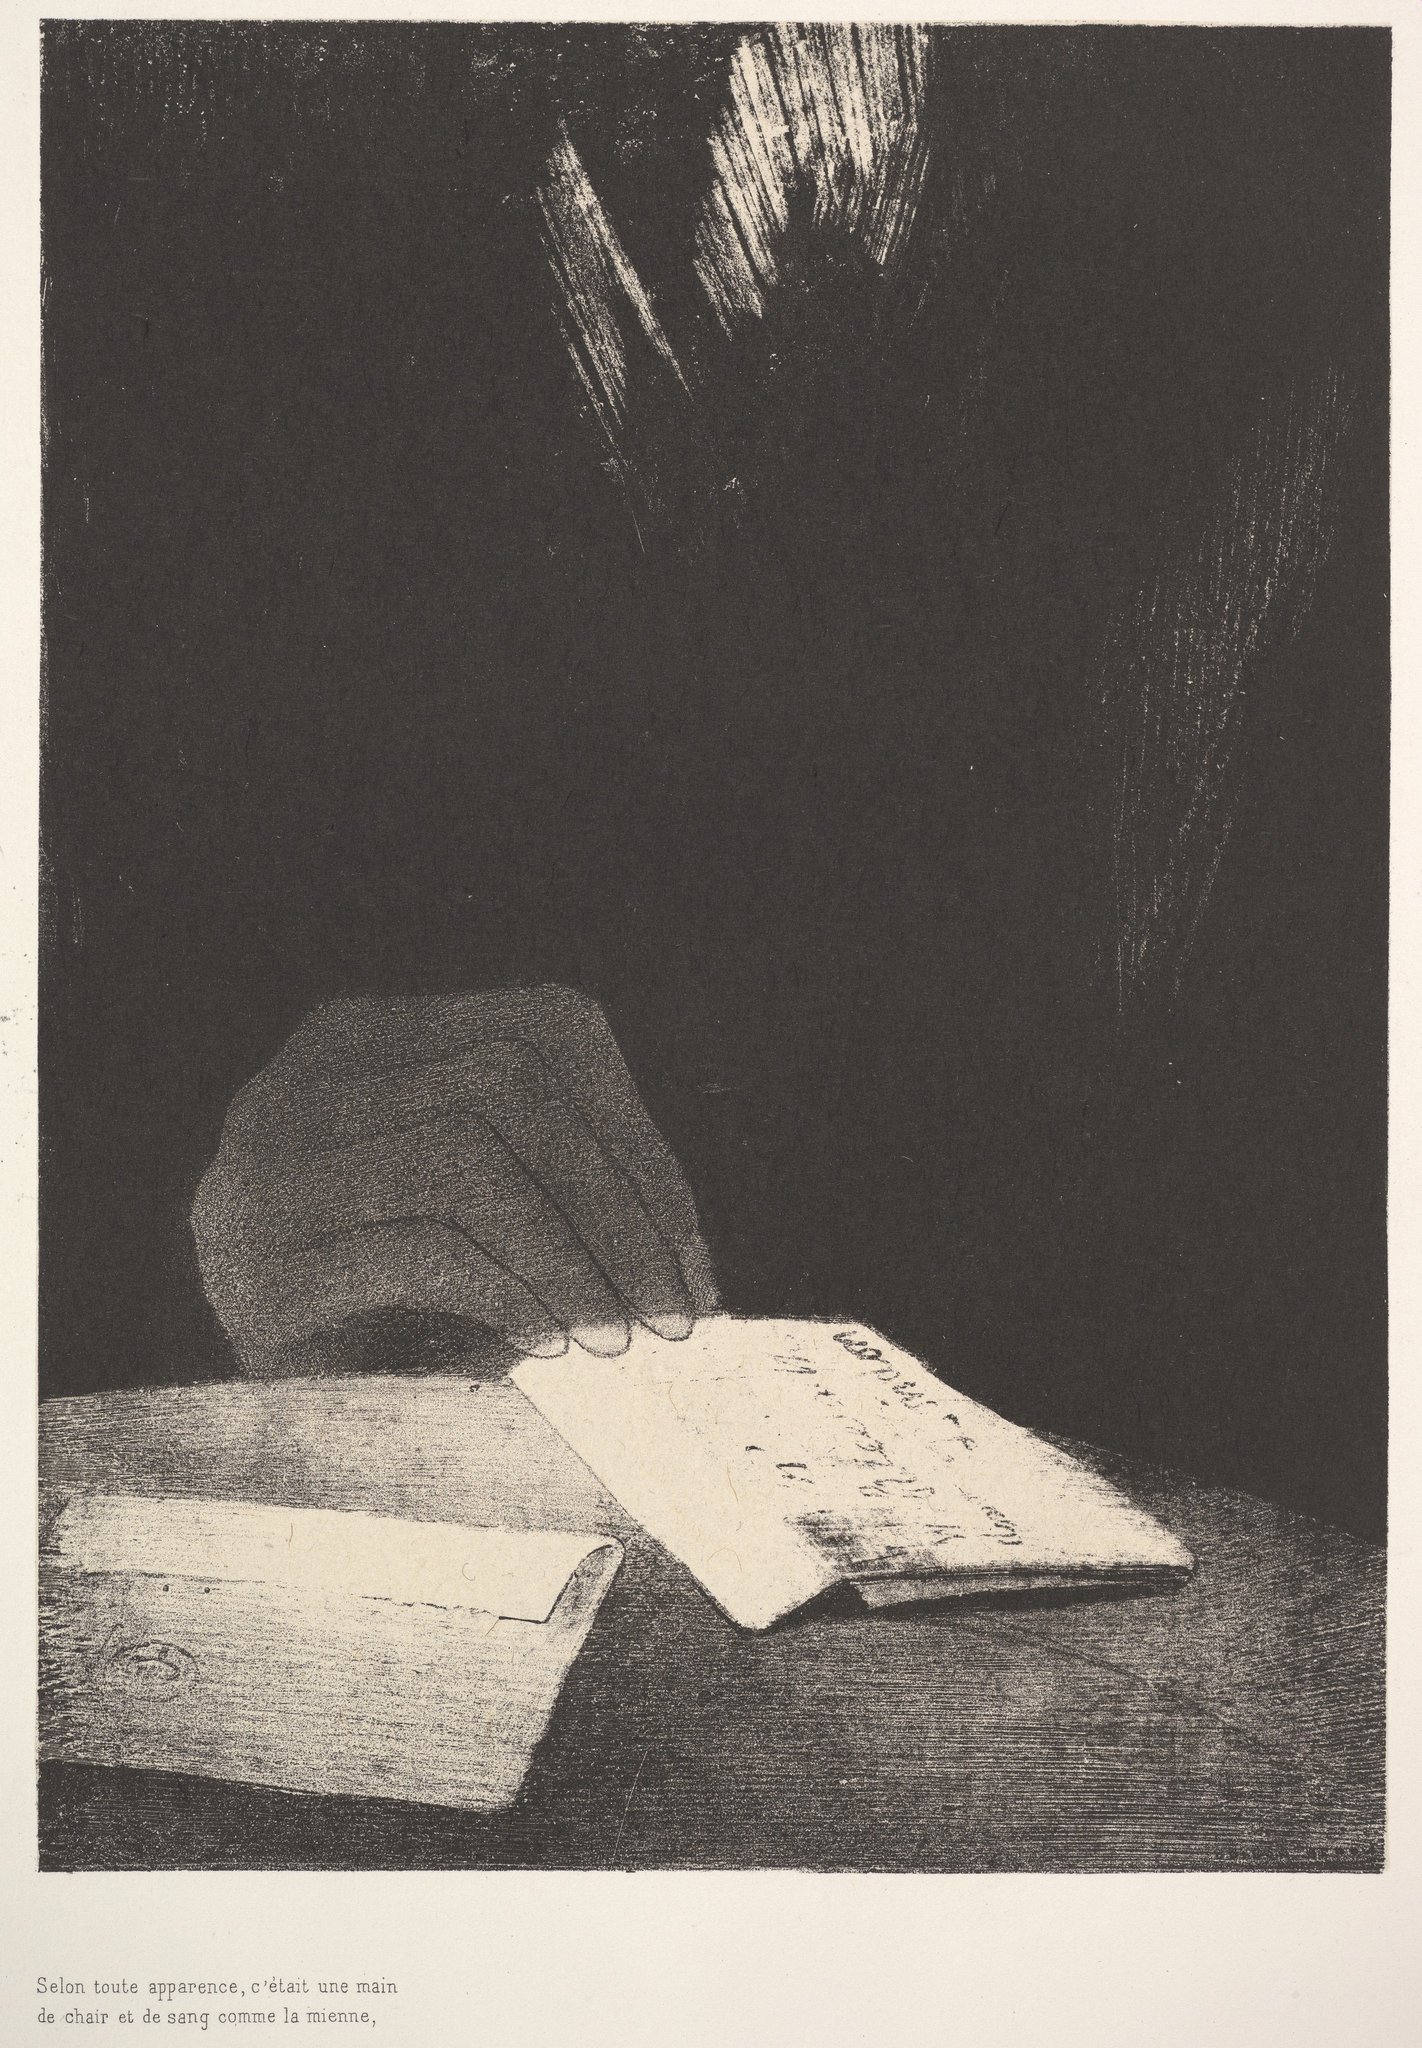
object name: print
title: To all appearances, it was a hand of flesh and blood just like my own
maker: odilon redon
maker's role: artist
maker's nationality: french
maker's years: 1840-1916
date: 1896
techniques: lithograph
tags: hands